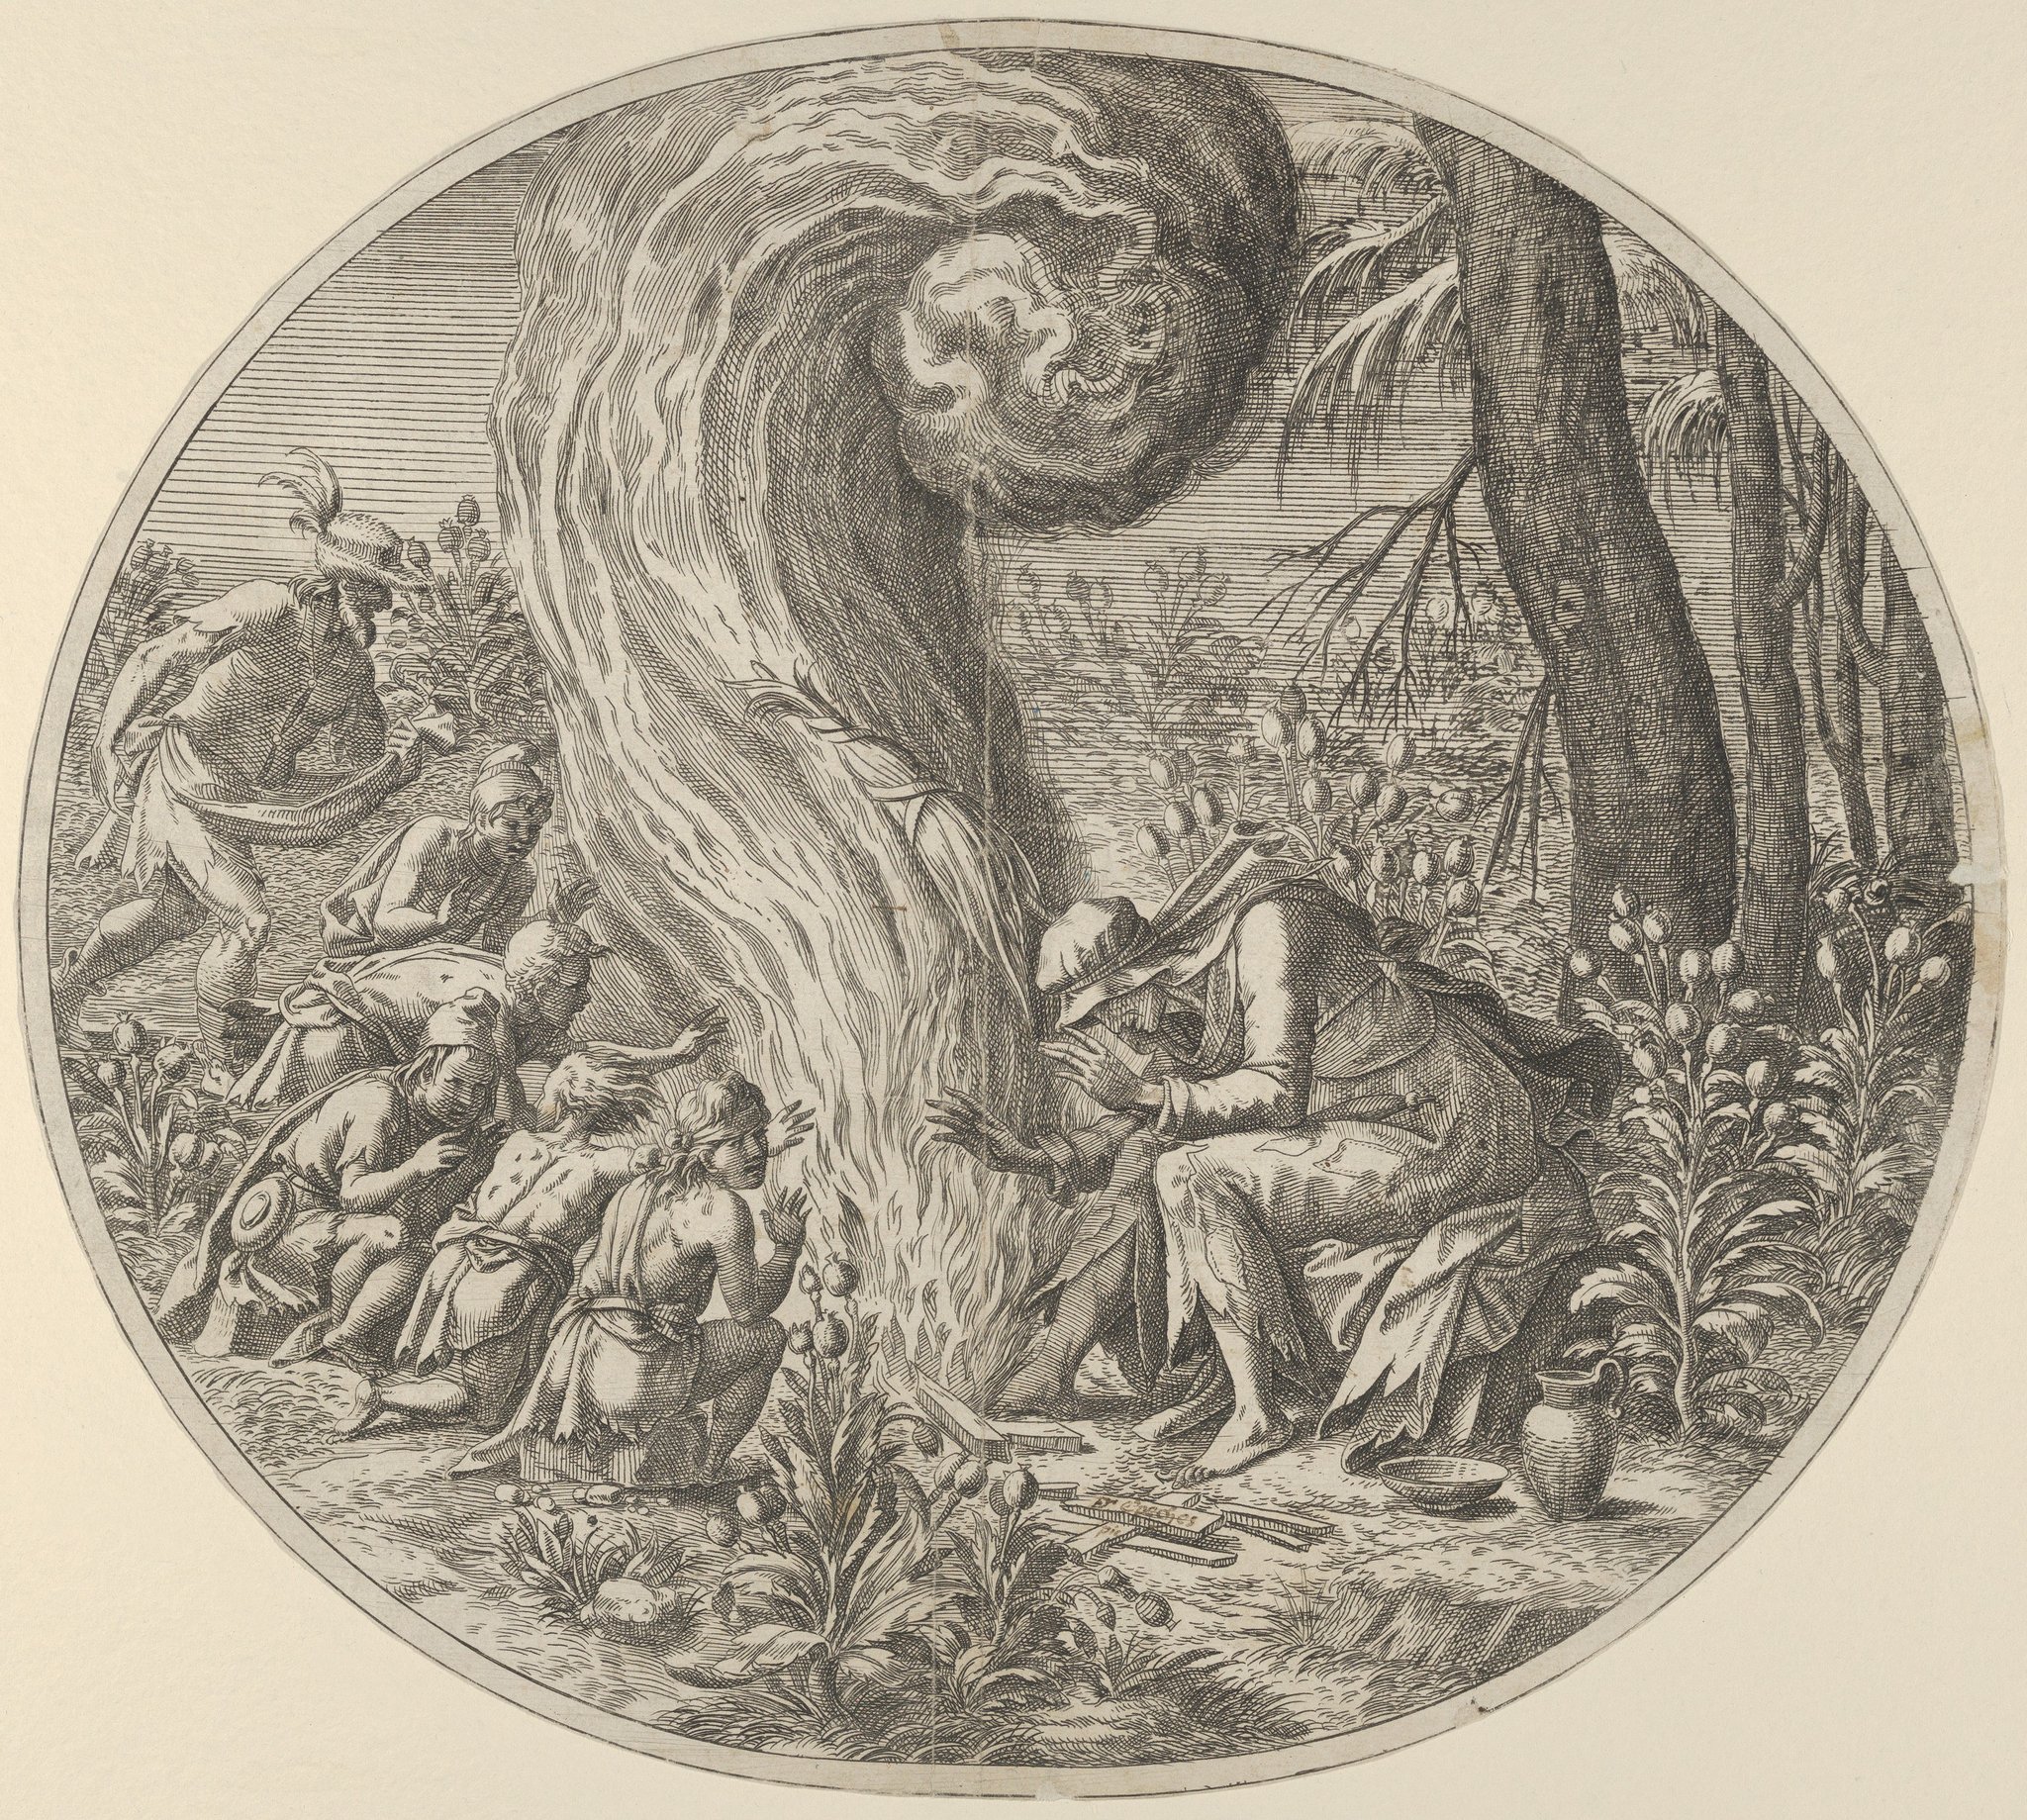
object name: print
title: Sloth, from the "Seven Deadly Sins"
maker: léon davent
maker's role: artist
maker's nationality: french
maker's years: 1540-1556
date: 1550-1555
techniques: etching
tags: boys,men,fire,trees